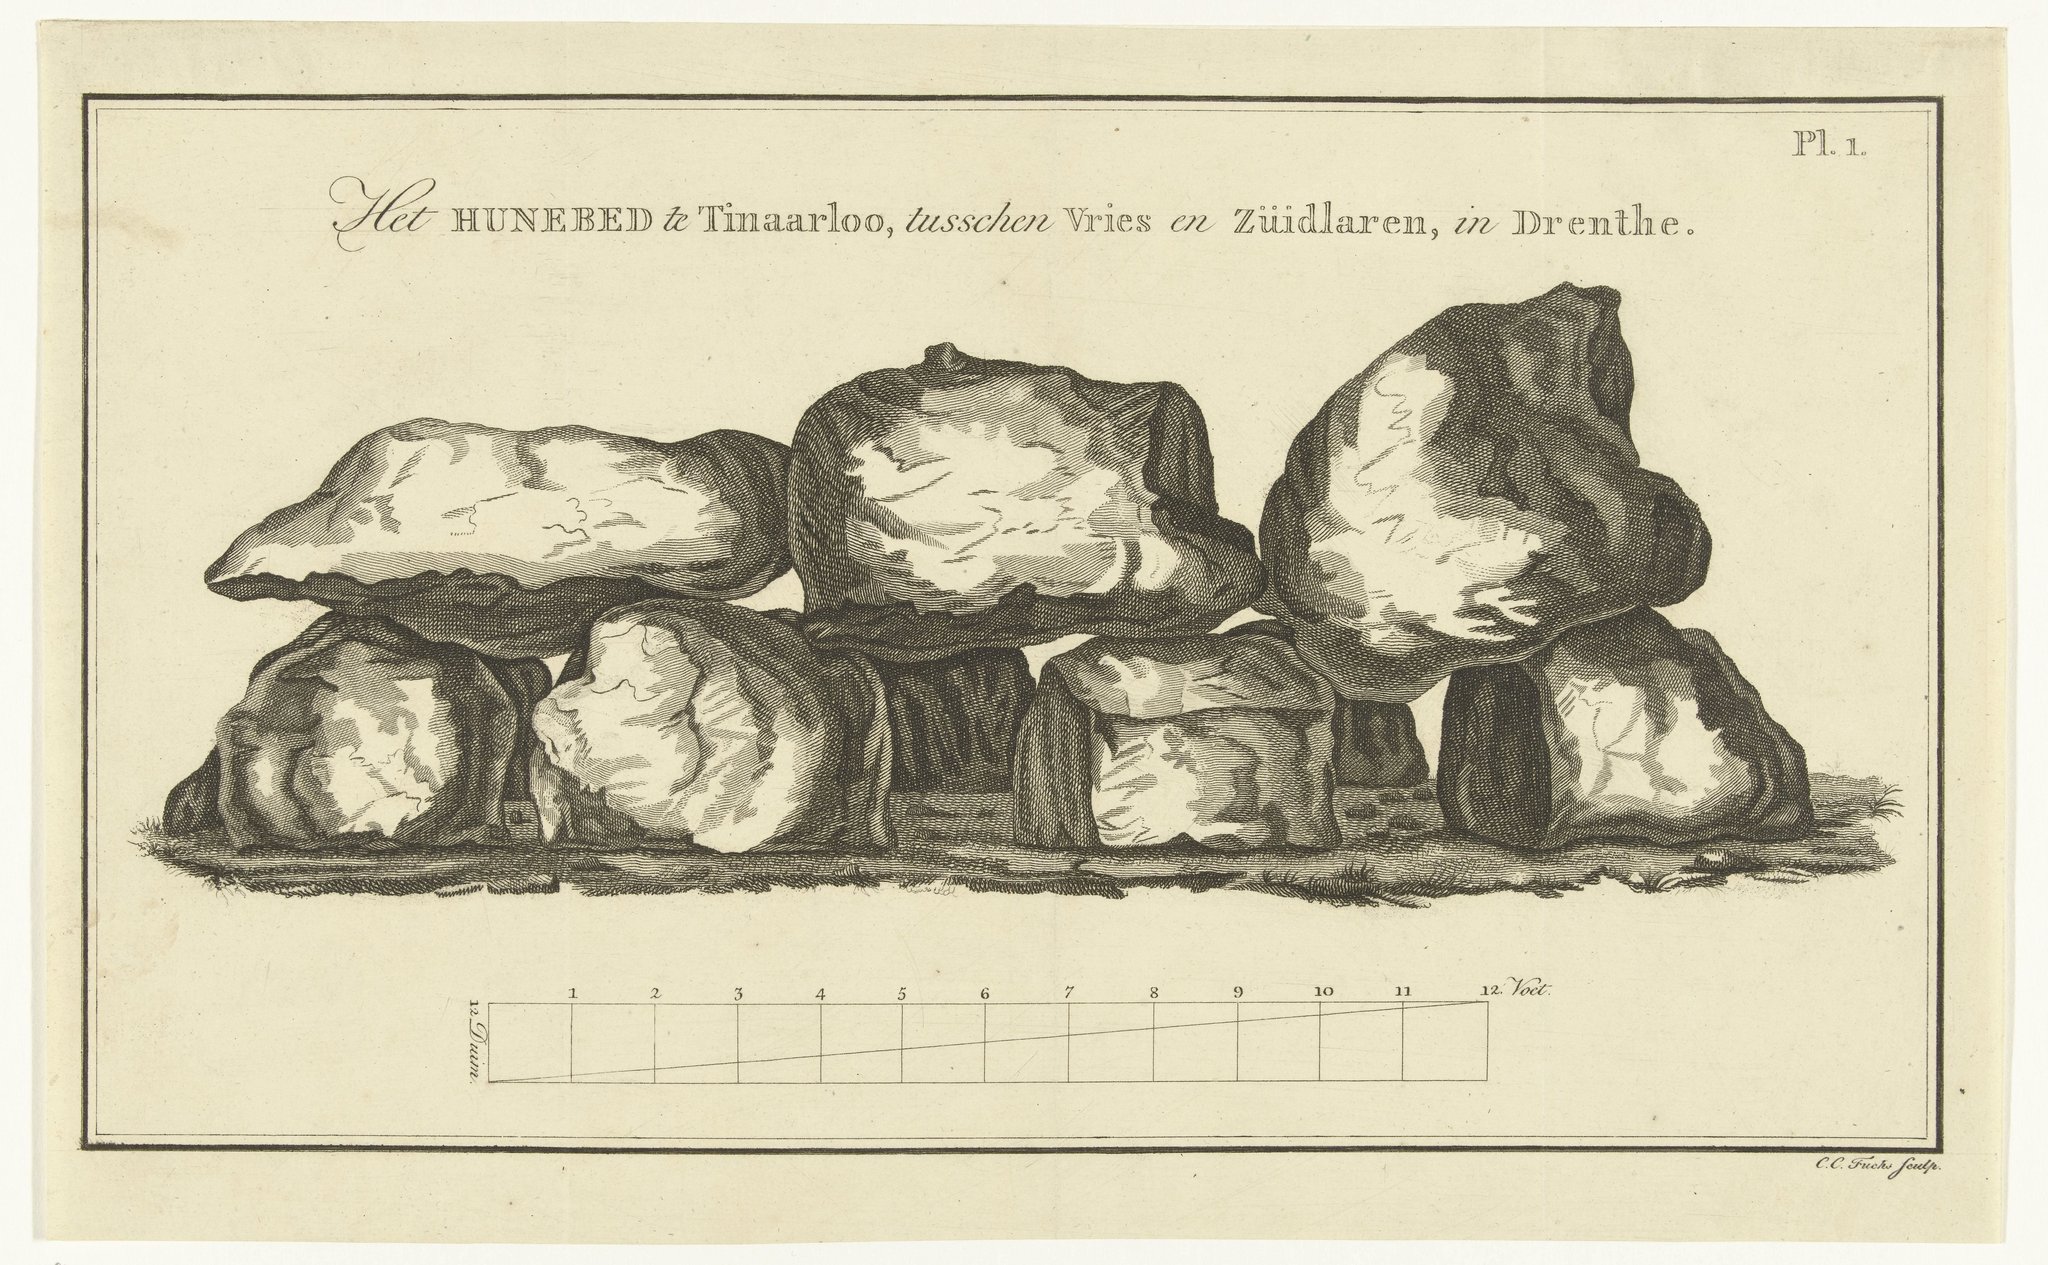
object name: print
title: Het hunebed te Tynaarlo in Drenthe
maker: karel christiaan fuchs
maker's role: draughtsman, print maker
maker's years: 1792-1855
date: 1820-1822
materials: paper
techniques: etching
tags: megalithic chambered tomb, dolmen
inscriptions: collector's mark: Lugt 2228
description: Illustratie voor: N. Westendorp, Verhandeling, ter beantwoording der vrage: welke volkeren hebben de zoogenoemde hunebedden gesticht? : In welke tijden kan men onderstellen, dat zij deze oorden hebben bewoond?, J. Oomkens (II), Groningen 1822, pl. 1.